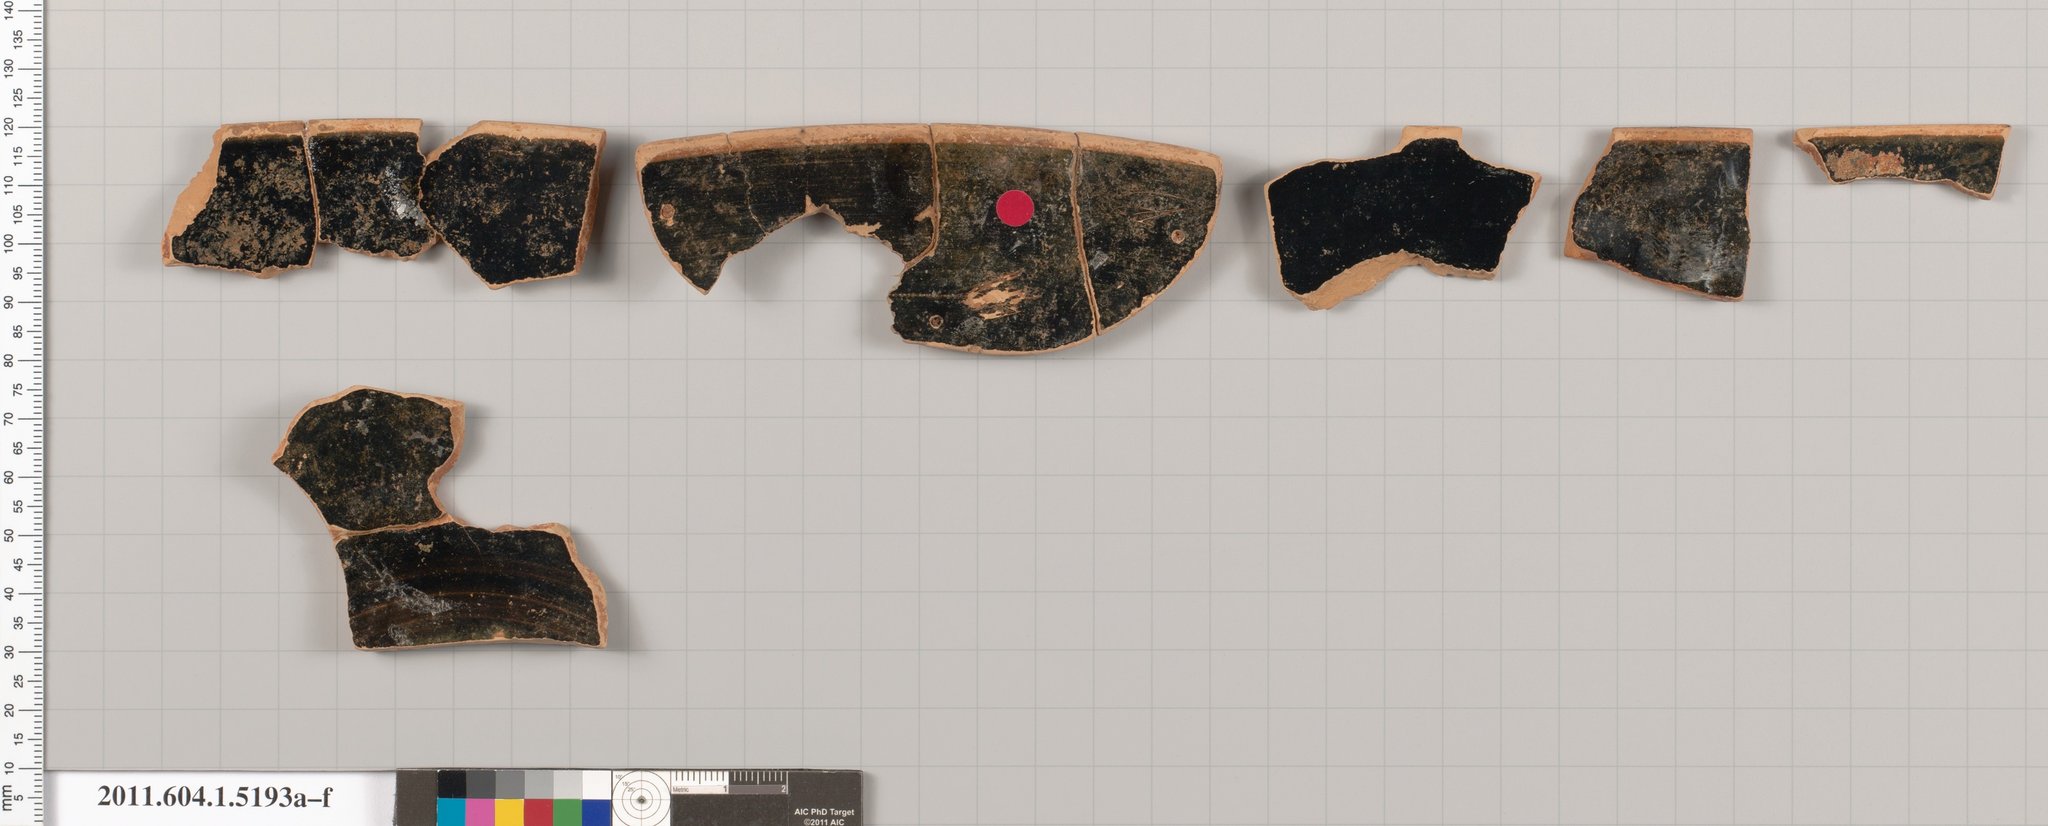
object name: kylix fragment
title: Terracotta fragments of a kylix (drinking cup)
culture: greek, attic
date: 520-500 BCE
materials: terracotta